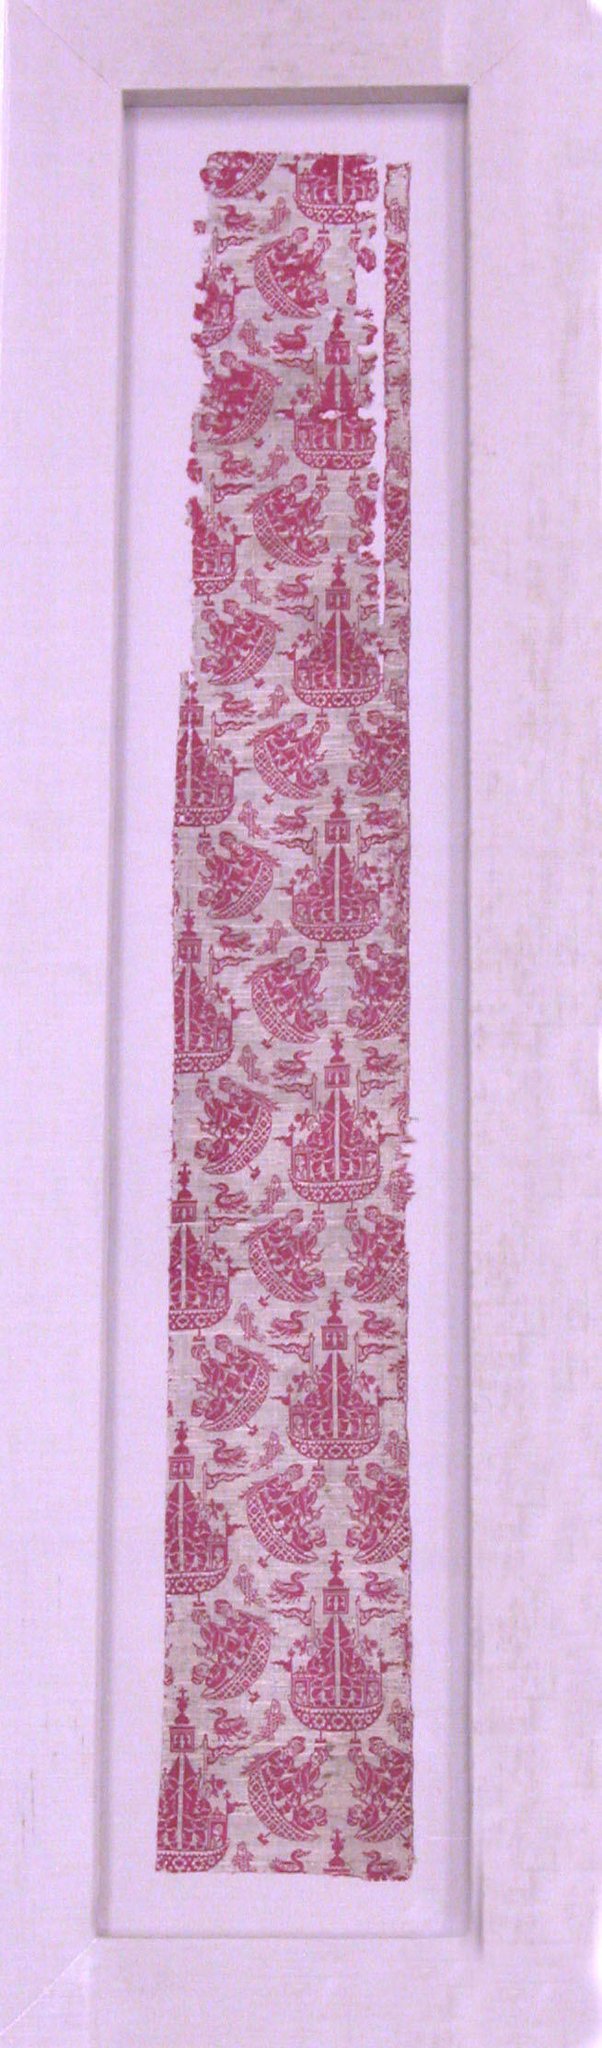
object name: textile fragment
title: Textile Fragment with Sailing Ships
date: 1600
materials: metal thread, silk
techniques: weave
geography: iran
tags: ducks,fish,sailors,ships